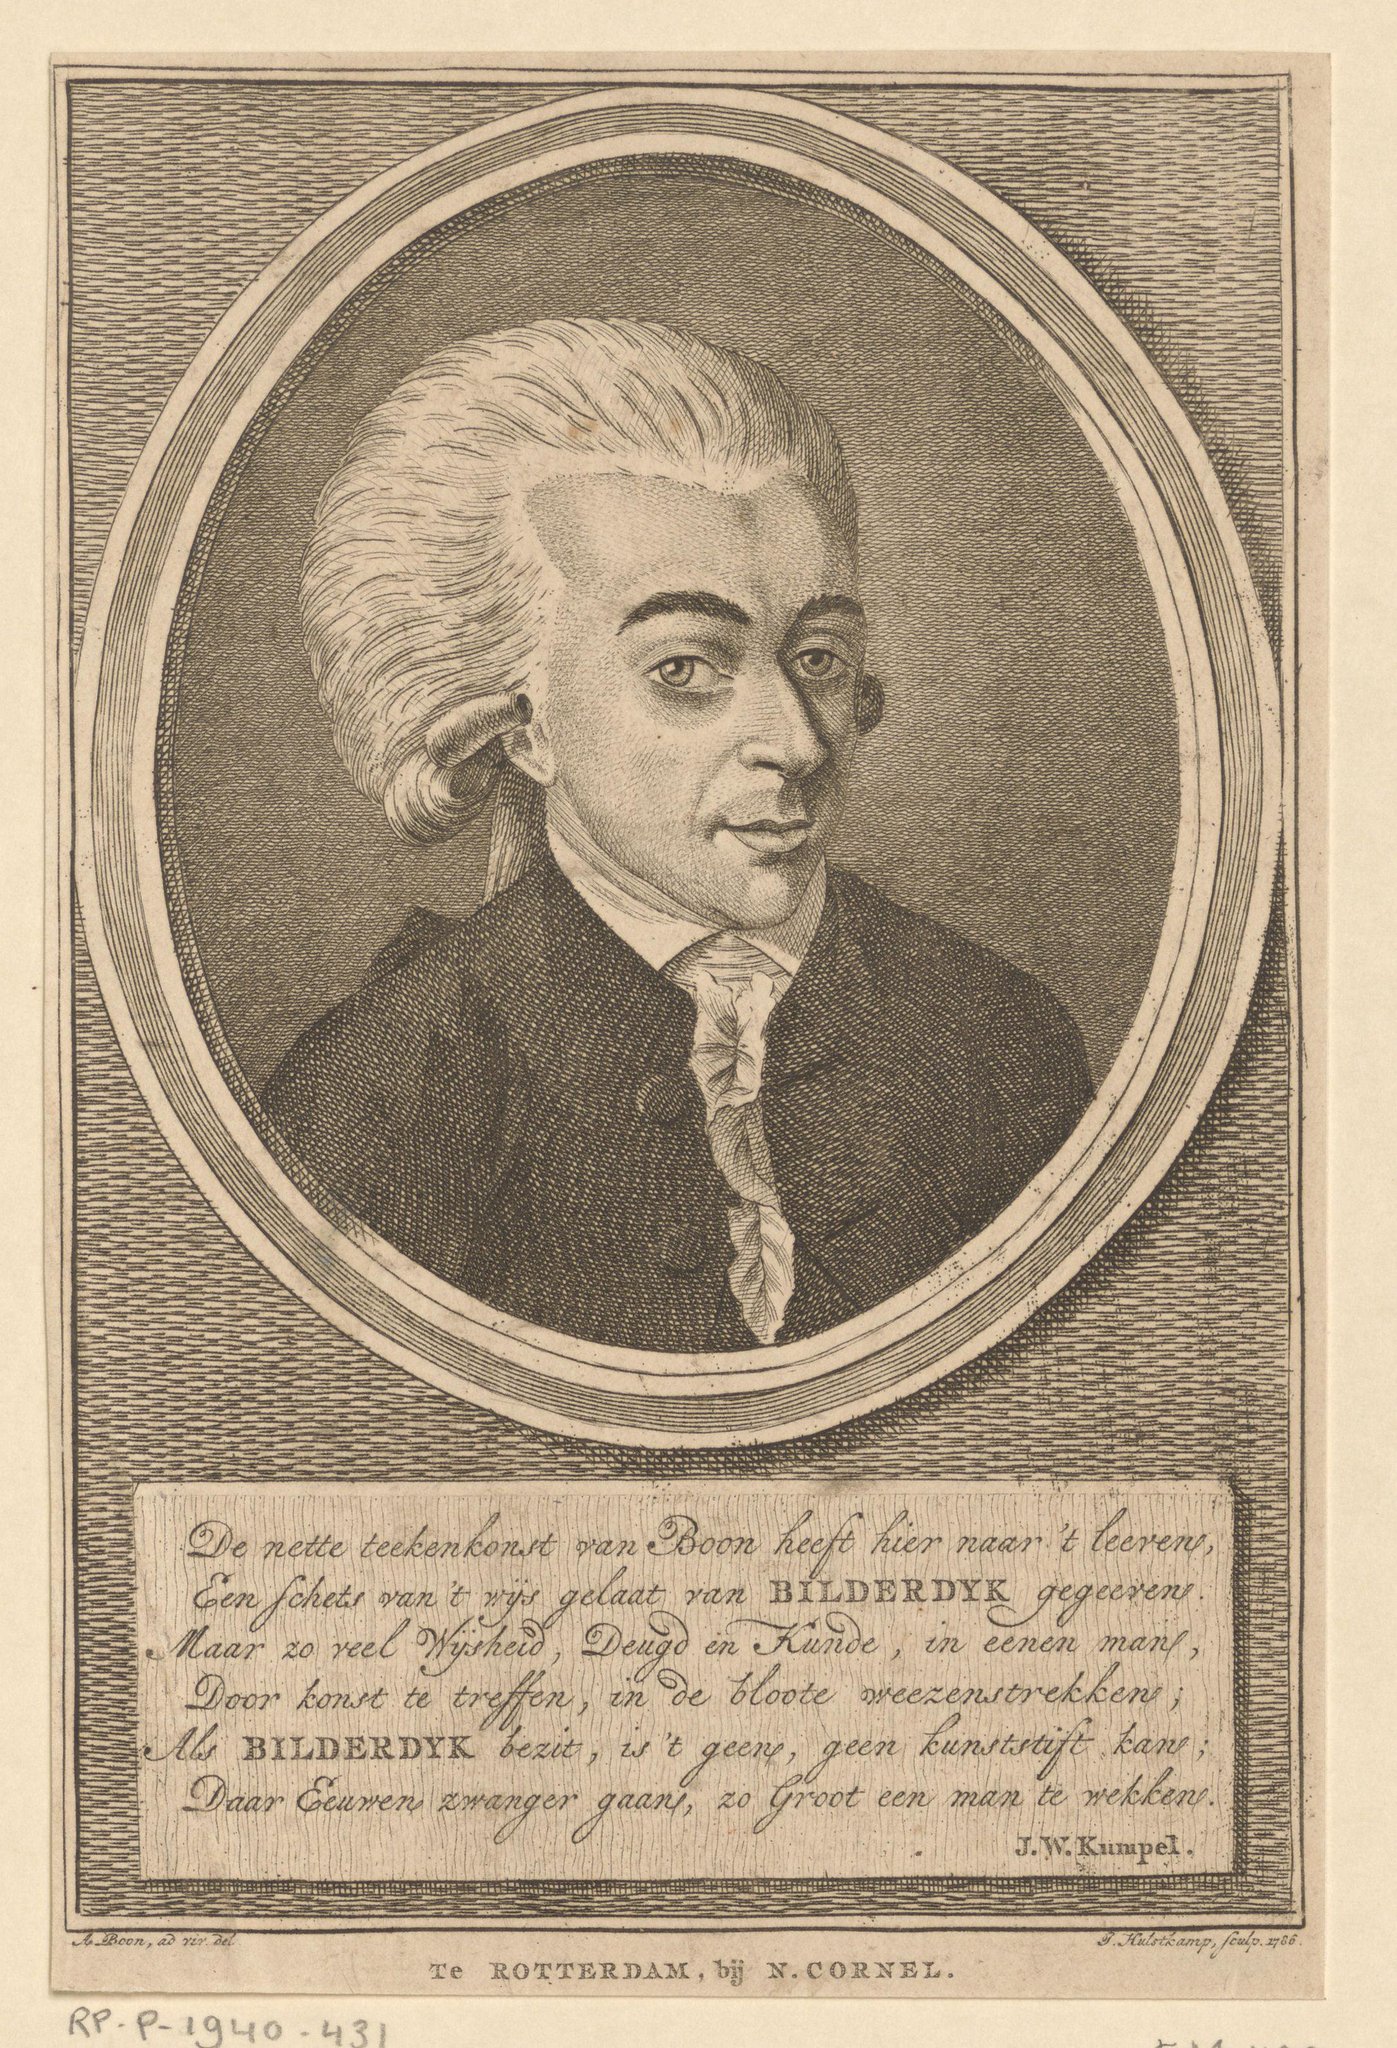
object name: print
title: Portret van Willem Bilderdijk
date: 1786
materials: paper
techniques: engraving, etching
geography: rotterdam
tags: amsterdam, haarlem, print maker, draughtsman, willem bilderdijk, historical persons, portrait of a writer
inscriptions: collector's mark: Lugt 2166, collector's mark: Lugt 2760